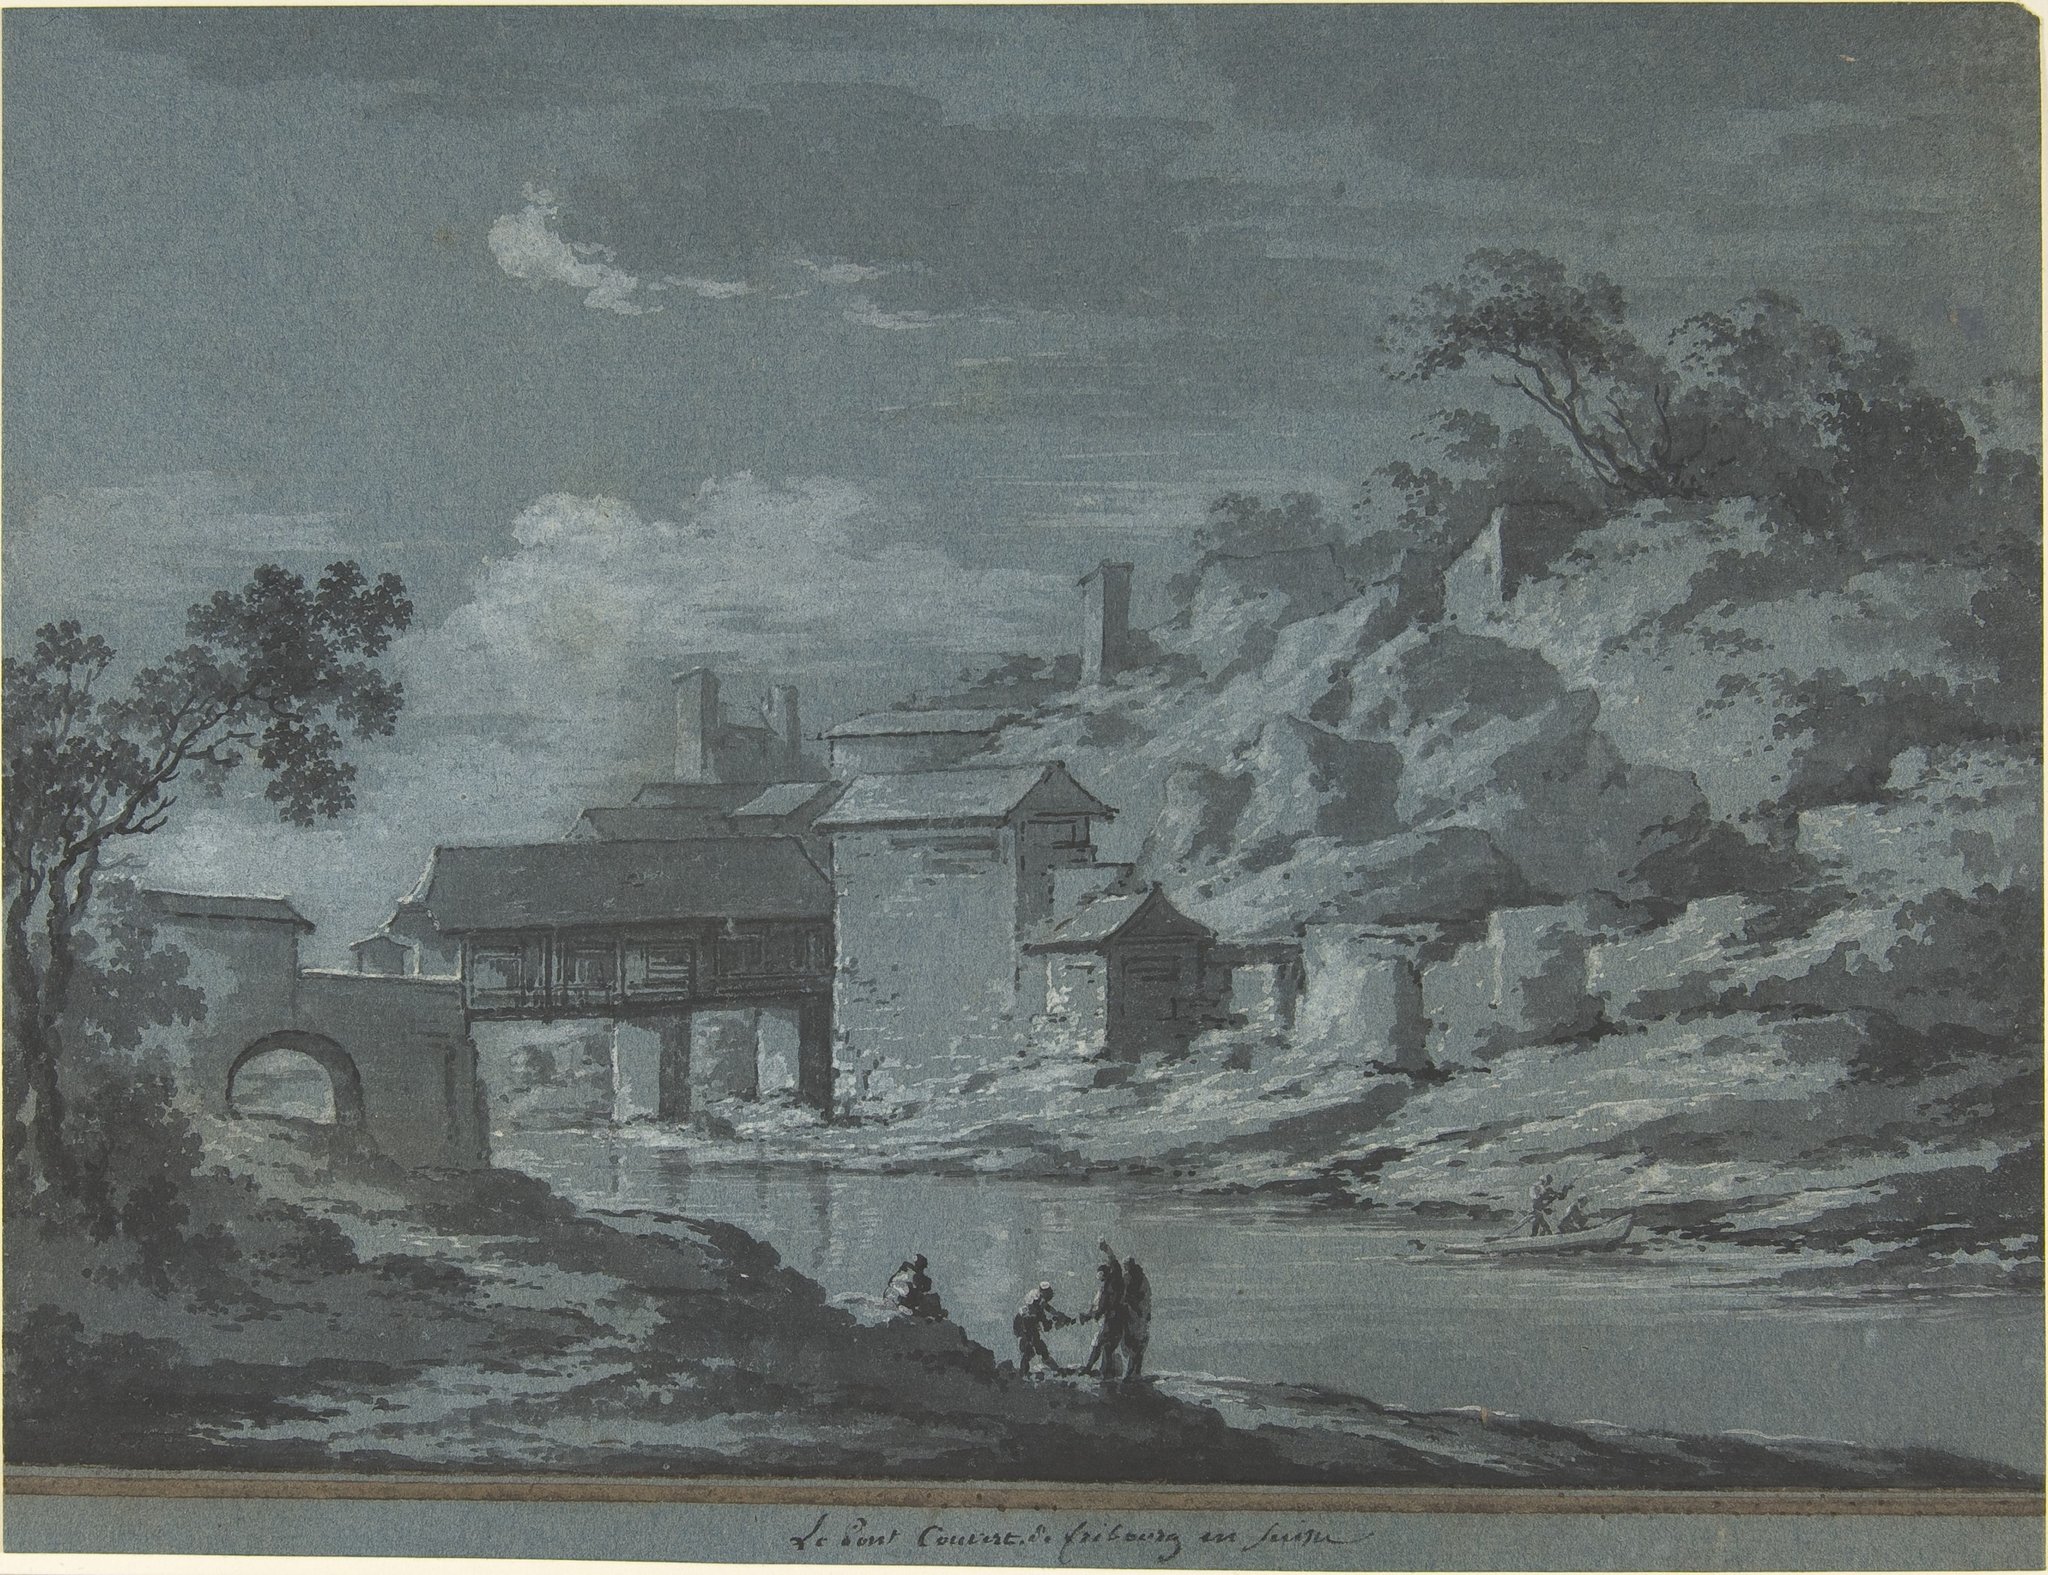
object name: drawing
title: The Covered Bridge at Fribourg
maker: claude louis châtelet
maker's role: artist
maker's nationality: french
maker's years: 1753-1794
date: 1701-1800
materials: ink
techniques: brush, heightening, pen, wash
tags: human figures,houses,bridges,landscapes,trees